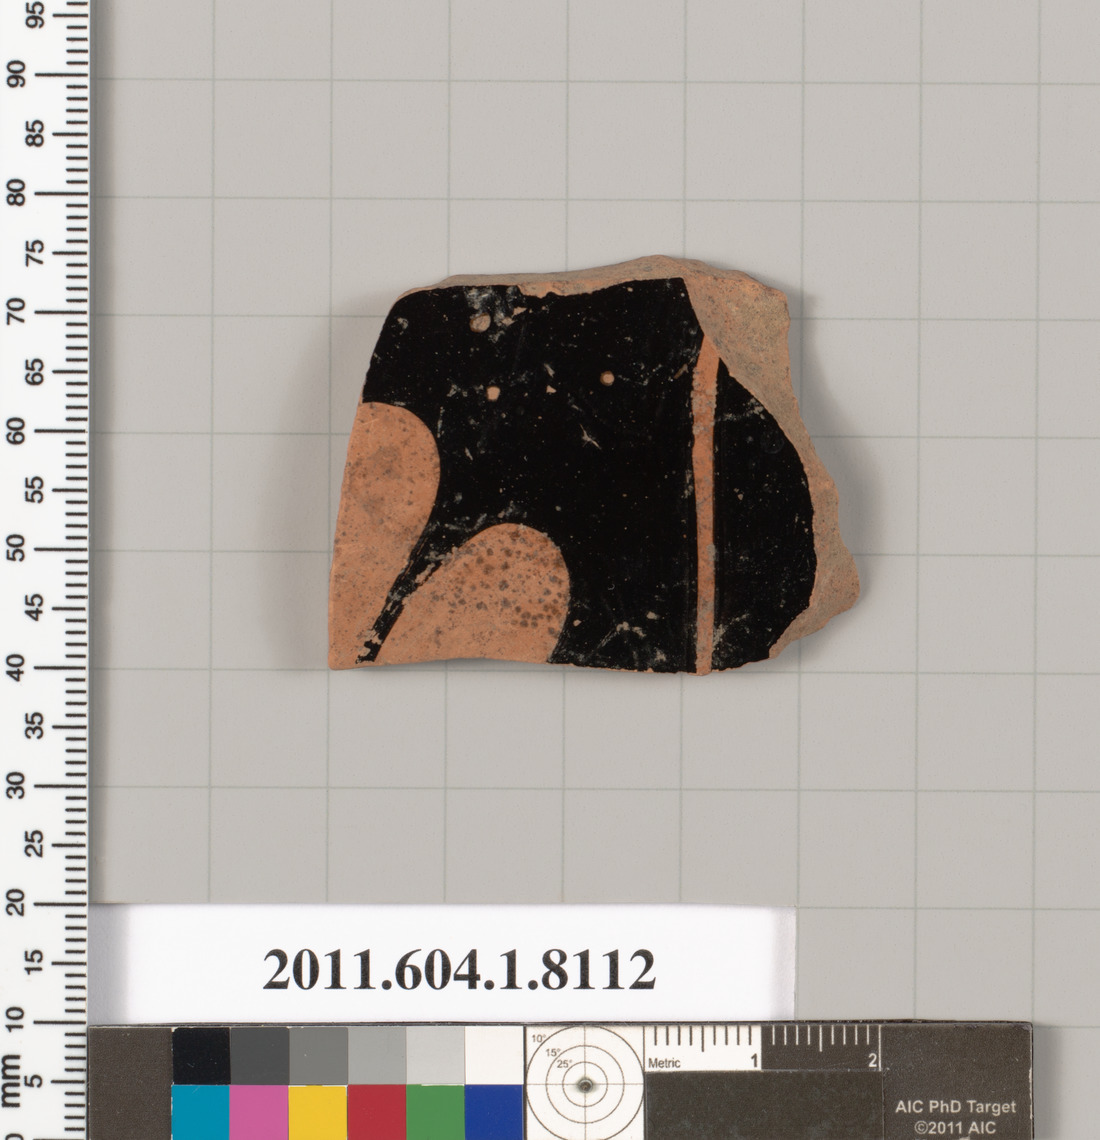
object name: kylix fragment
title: Terracotta fragment of a kylix (drinking cup)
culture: greek, attic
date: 534-468 BCE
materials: terracotta